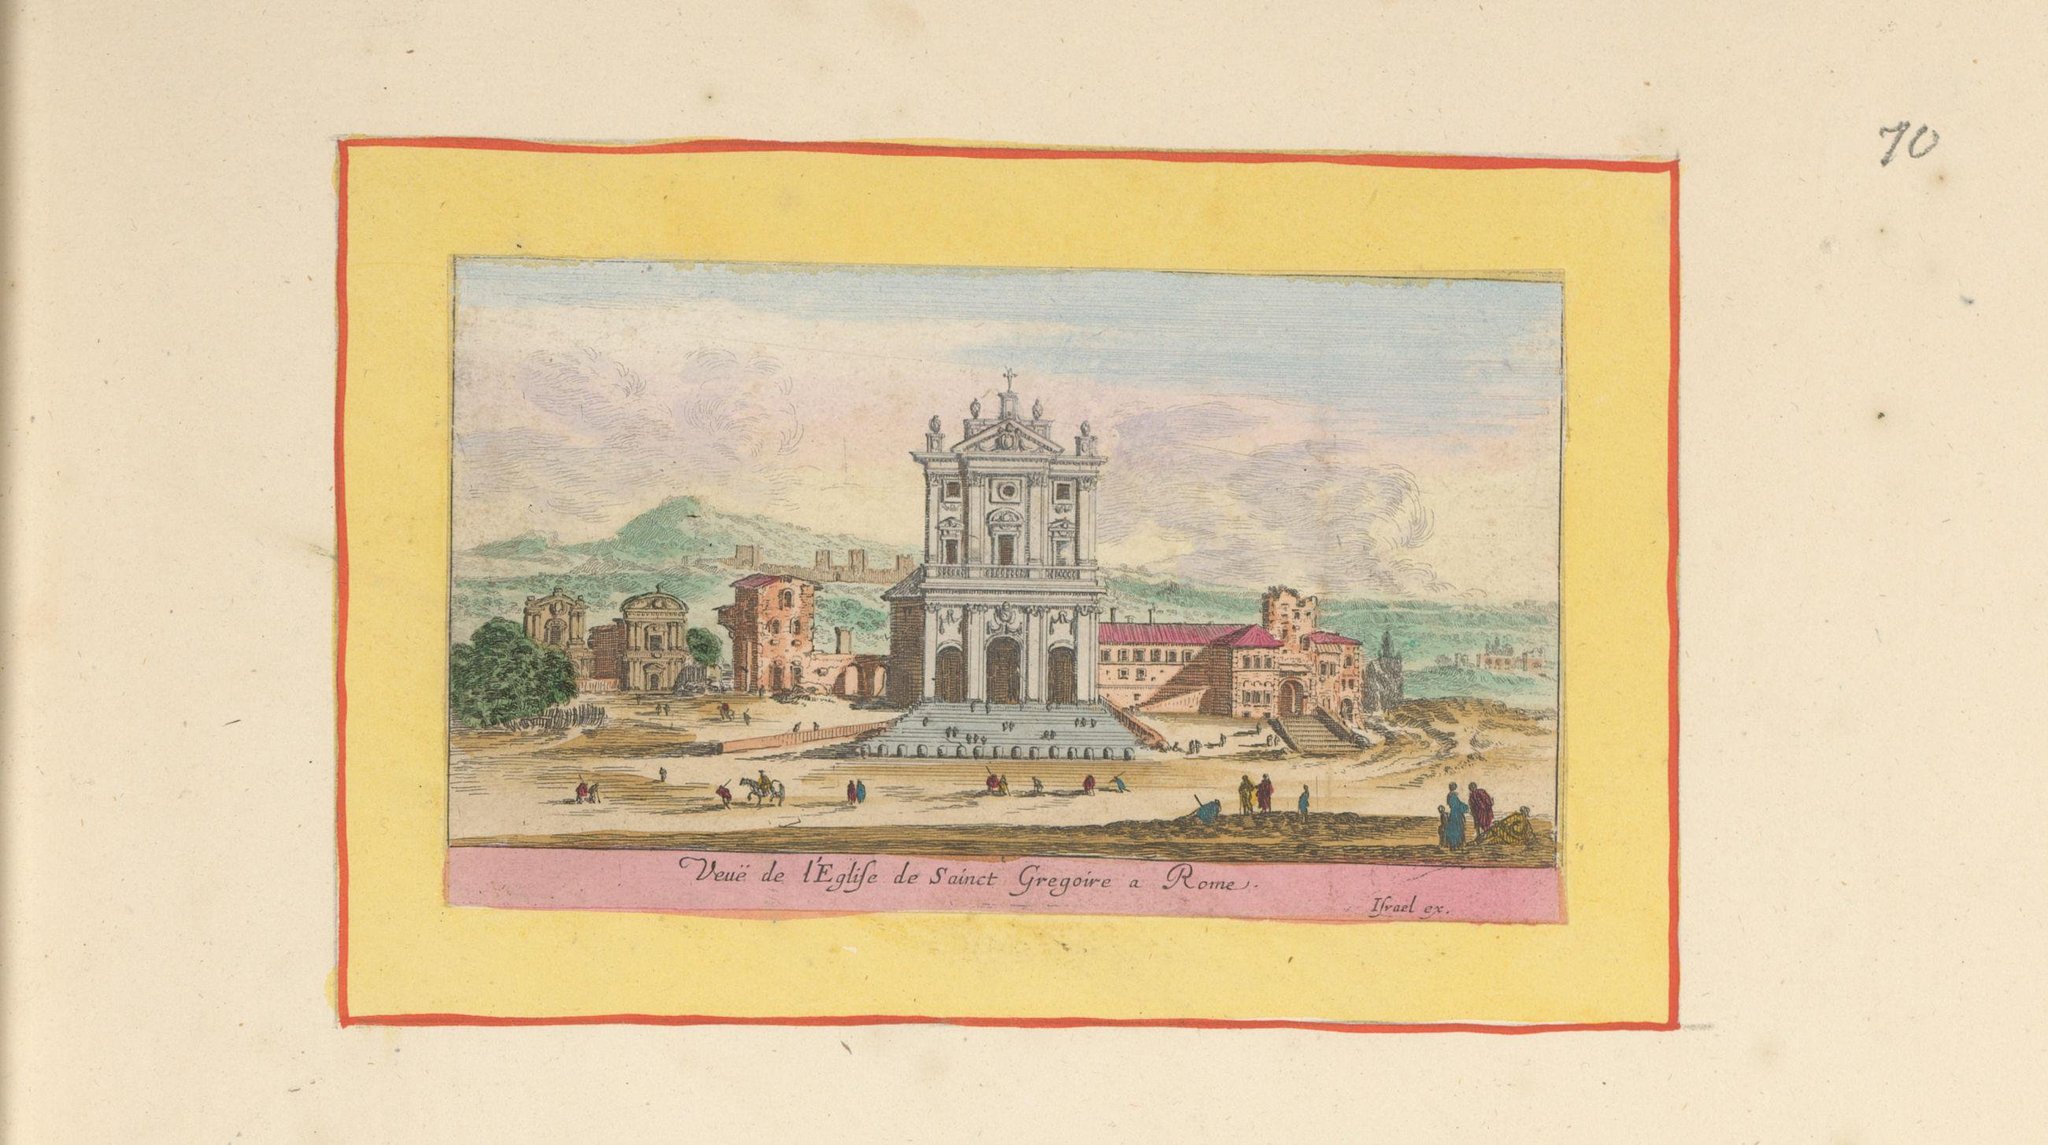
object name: print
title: Gezichten op Italië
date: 1631-1691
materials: paper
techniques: colour, etching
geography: the hague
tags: city-view, and landscape with man-made constructions, church (exterior)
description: Gezicht op de San Gregorio Magno al Celio te Rome. Titel in het Frans in de ondermarge. Prent maakt deel uit van een album.